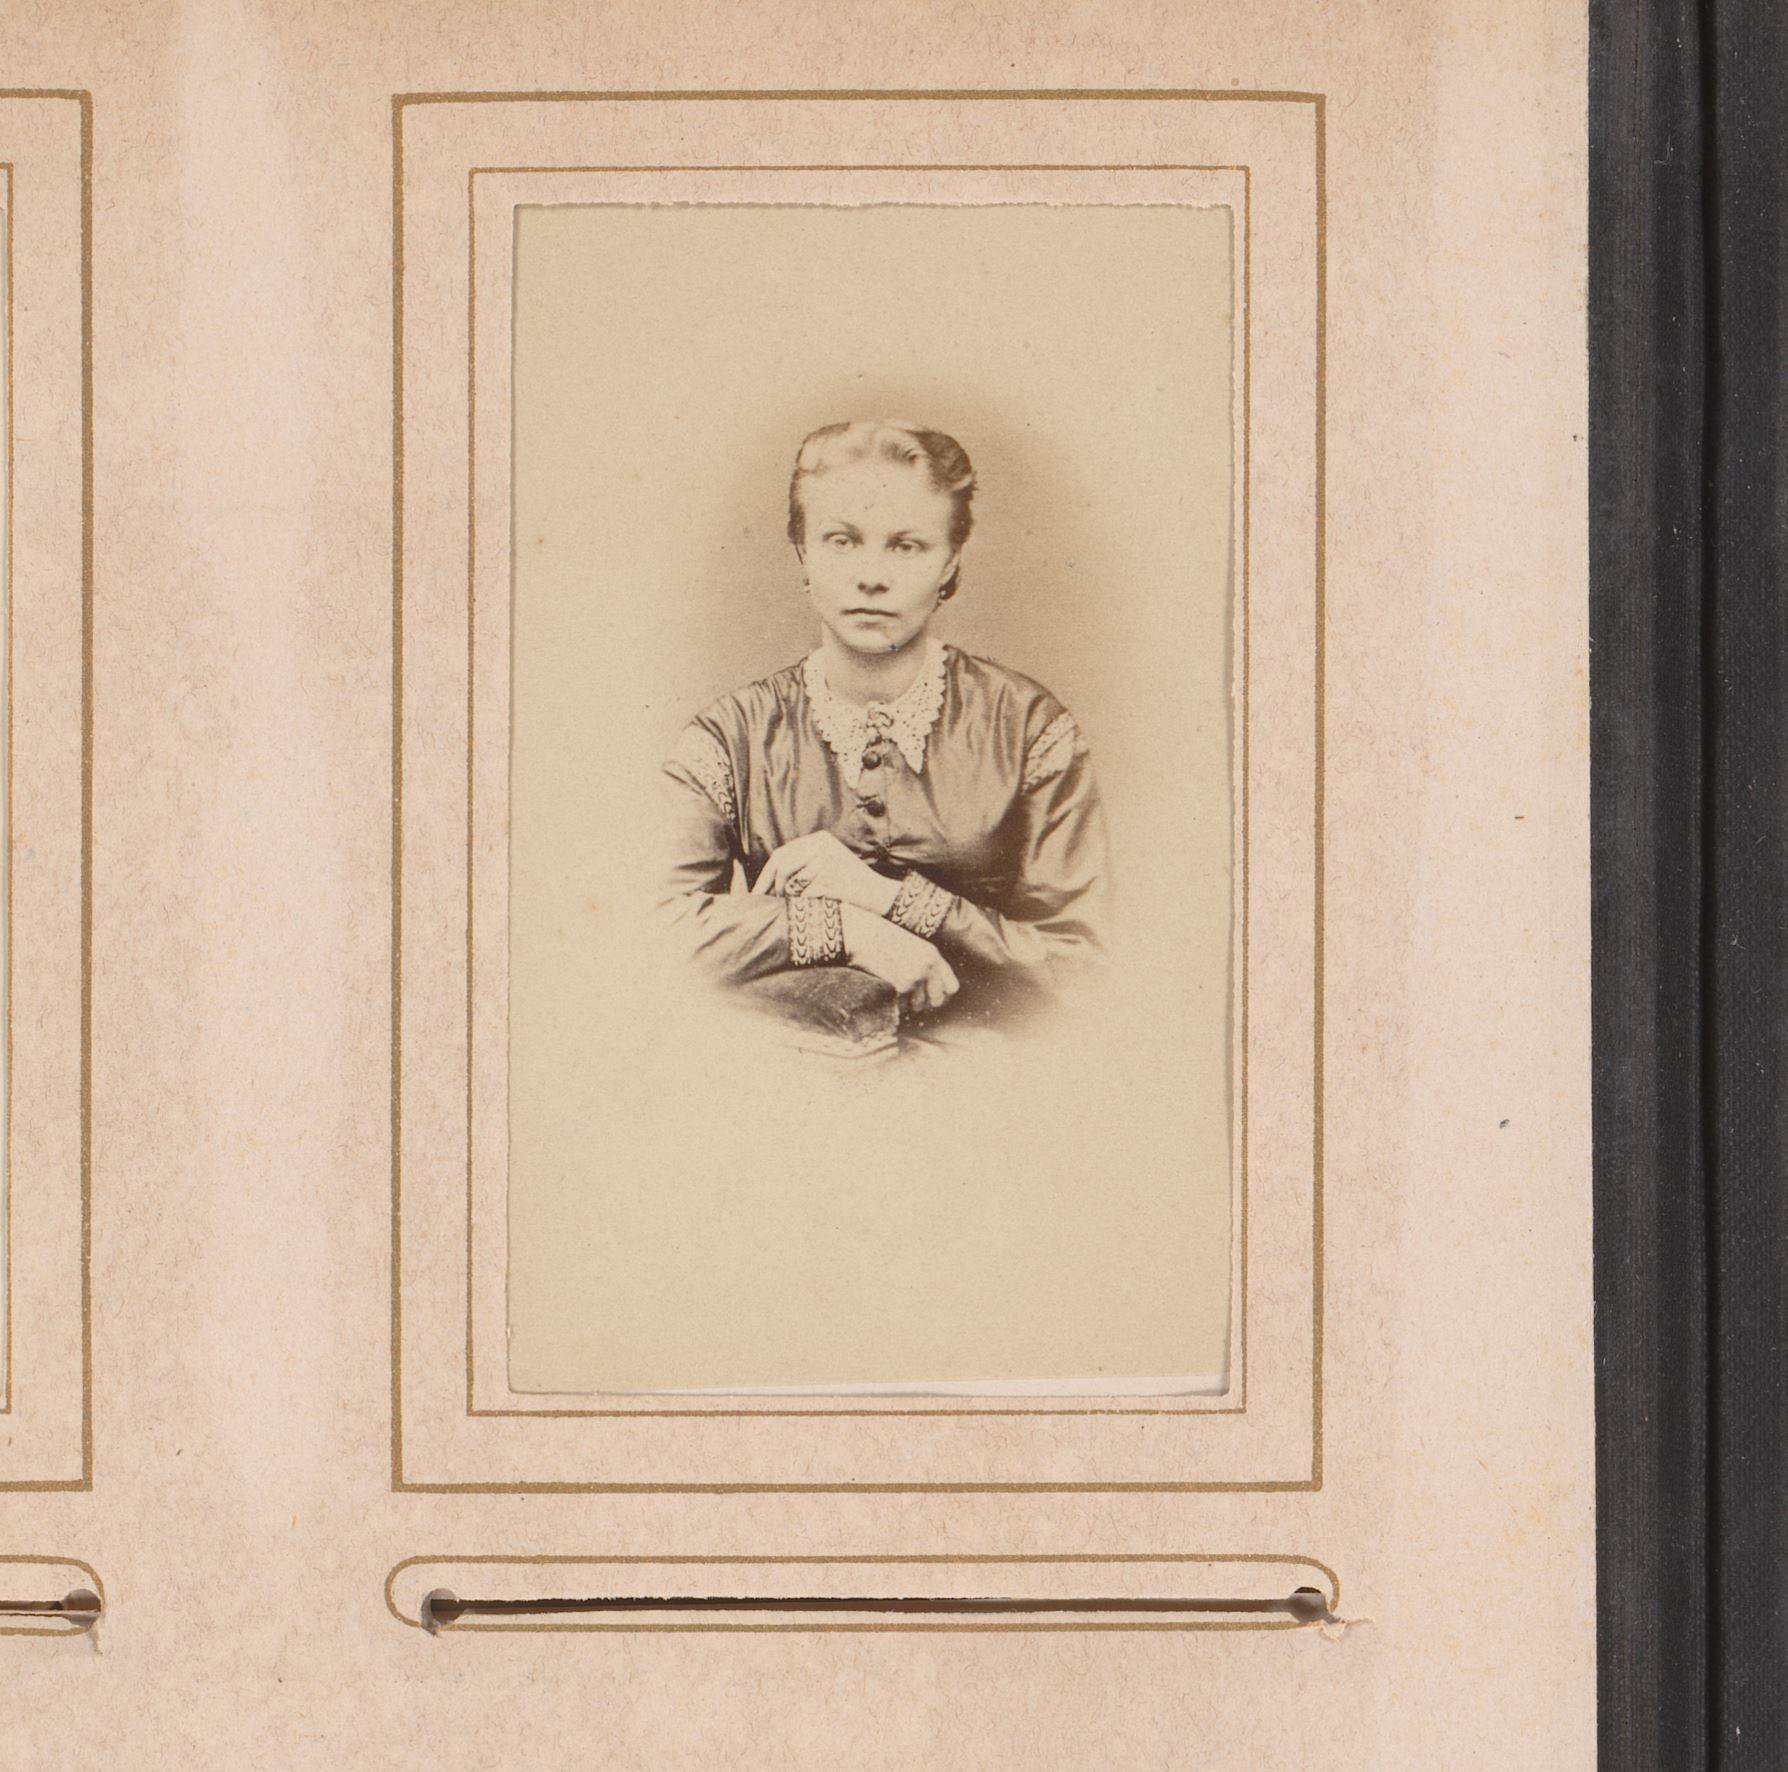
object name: carte de visite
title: Portret van een vrouw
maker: albert greiner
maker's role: fotograaf, fotostudio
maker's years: 1833-1890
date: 1861-1874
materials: cardboard, photographic support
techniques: albumen print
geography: amsterdam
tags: historical persons - bb - woman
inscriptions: inscription: ‘A. Greiner/ Photograf/ Nieuwendijk L.87/ Amsterdam’